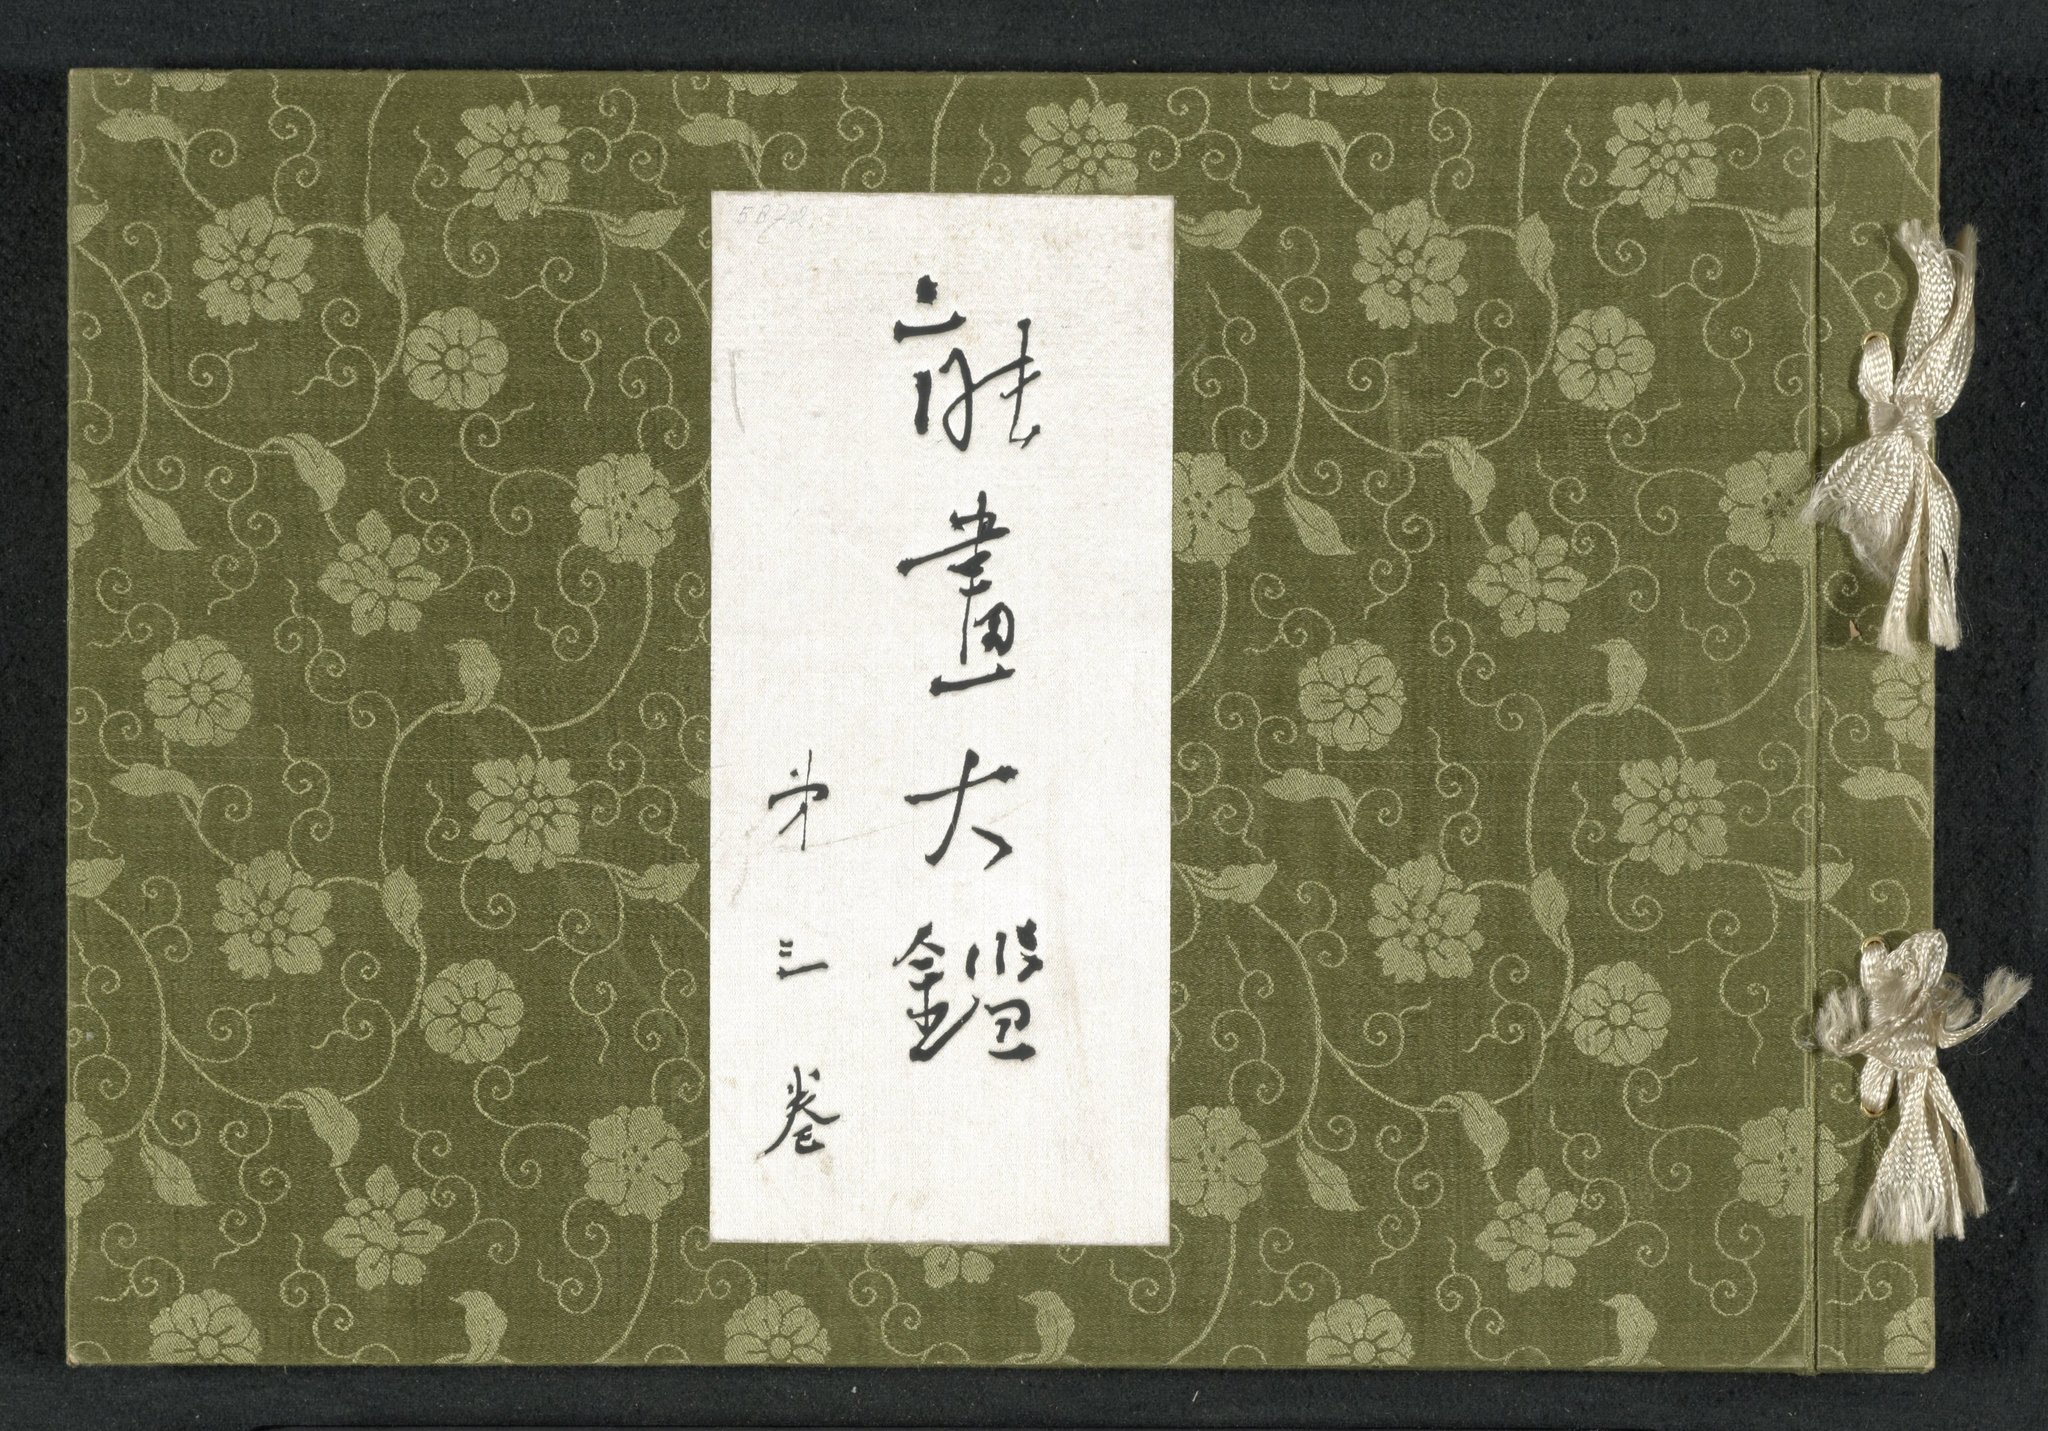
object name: picture book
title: Enceclopedie van Noh toneelstukken - deel twee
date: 1925-1926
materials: cardboard, paper, ribbon, silk, textile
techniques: woodcut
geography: japan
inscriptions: collector's mark: ‘Rijks-Ethnographisch Museum’